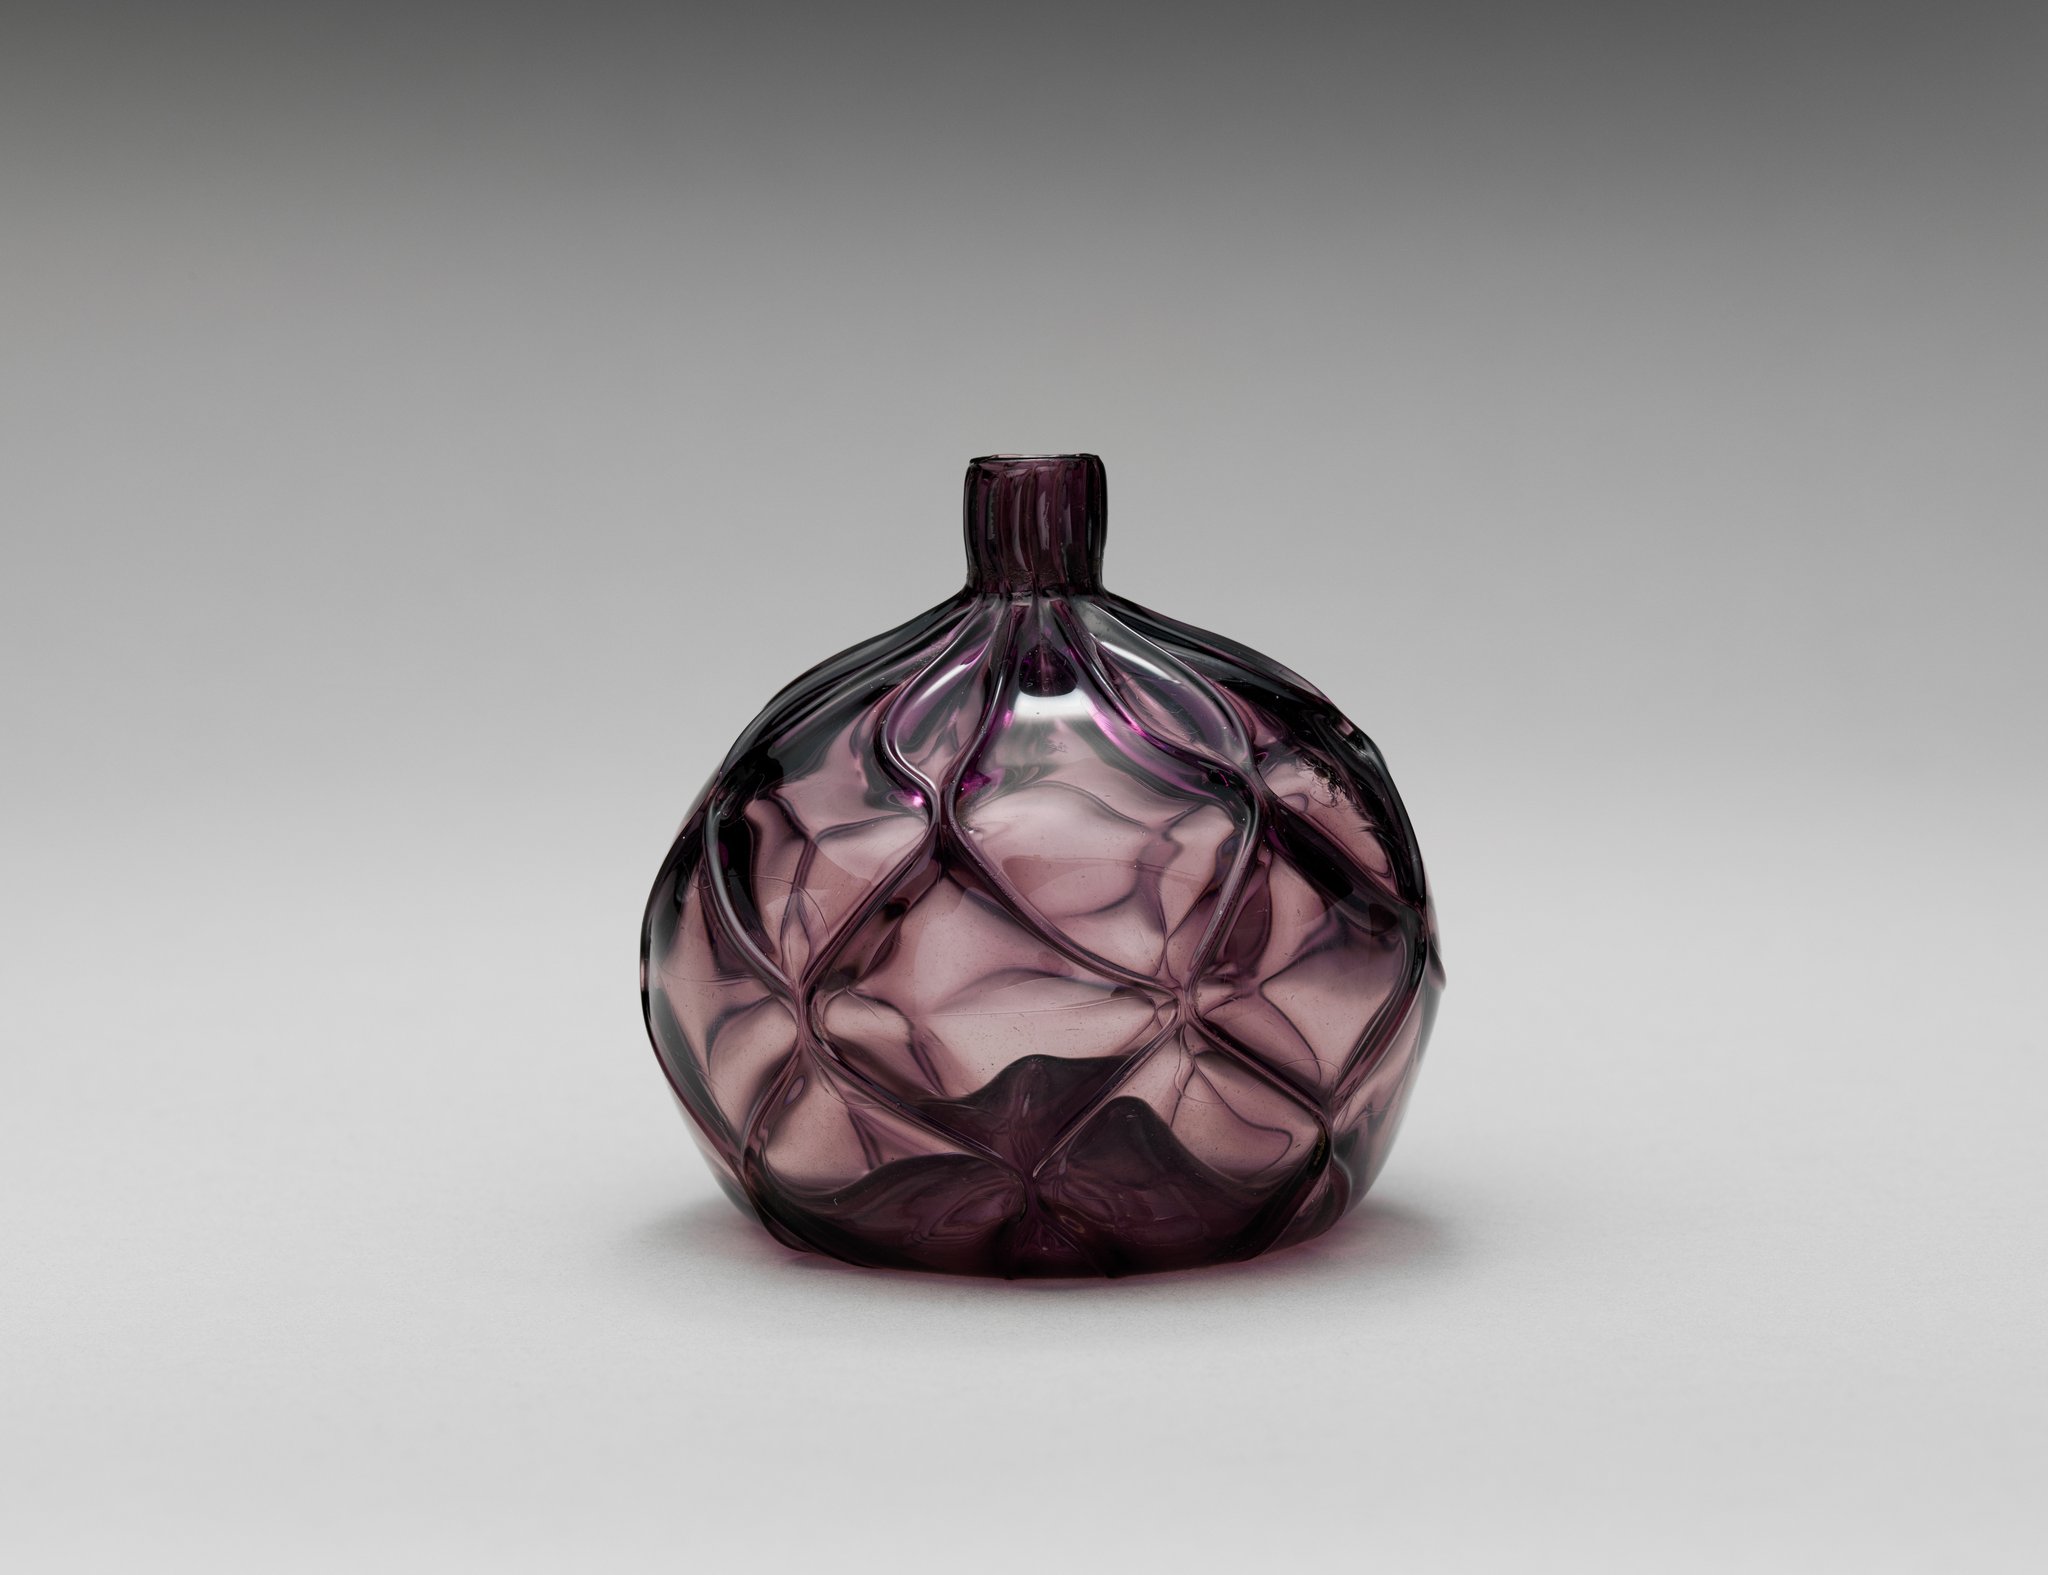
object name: flask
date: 1701-1800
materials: glass